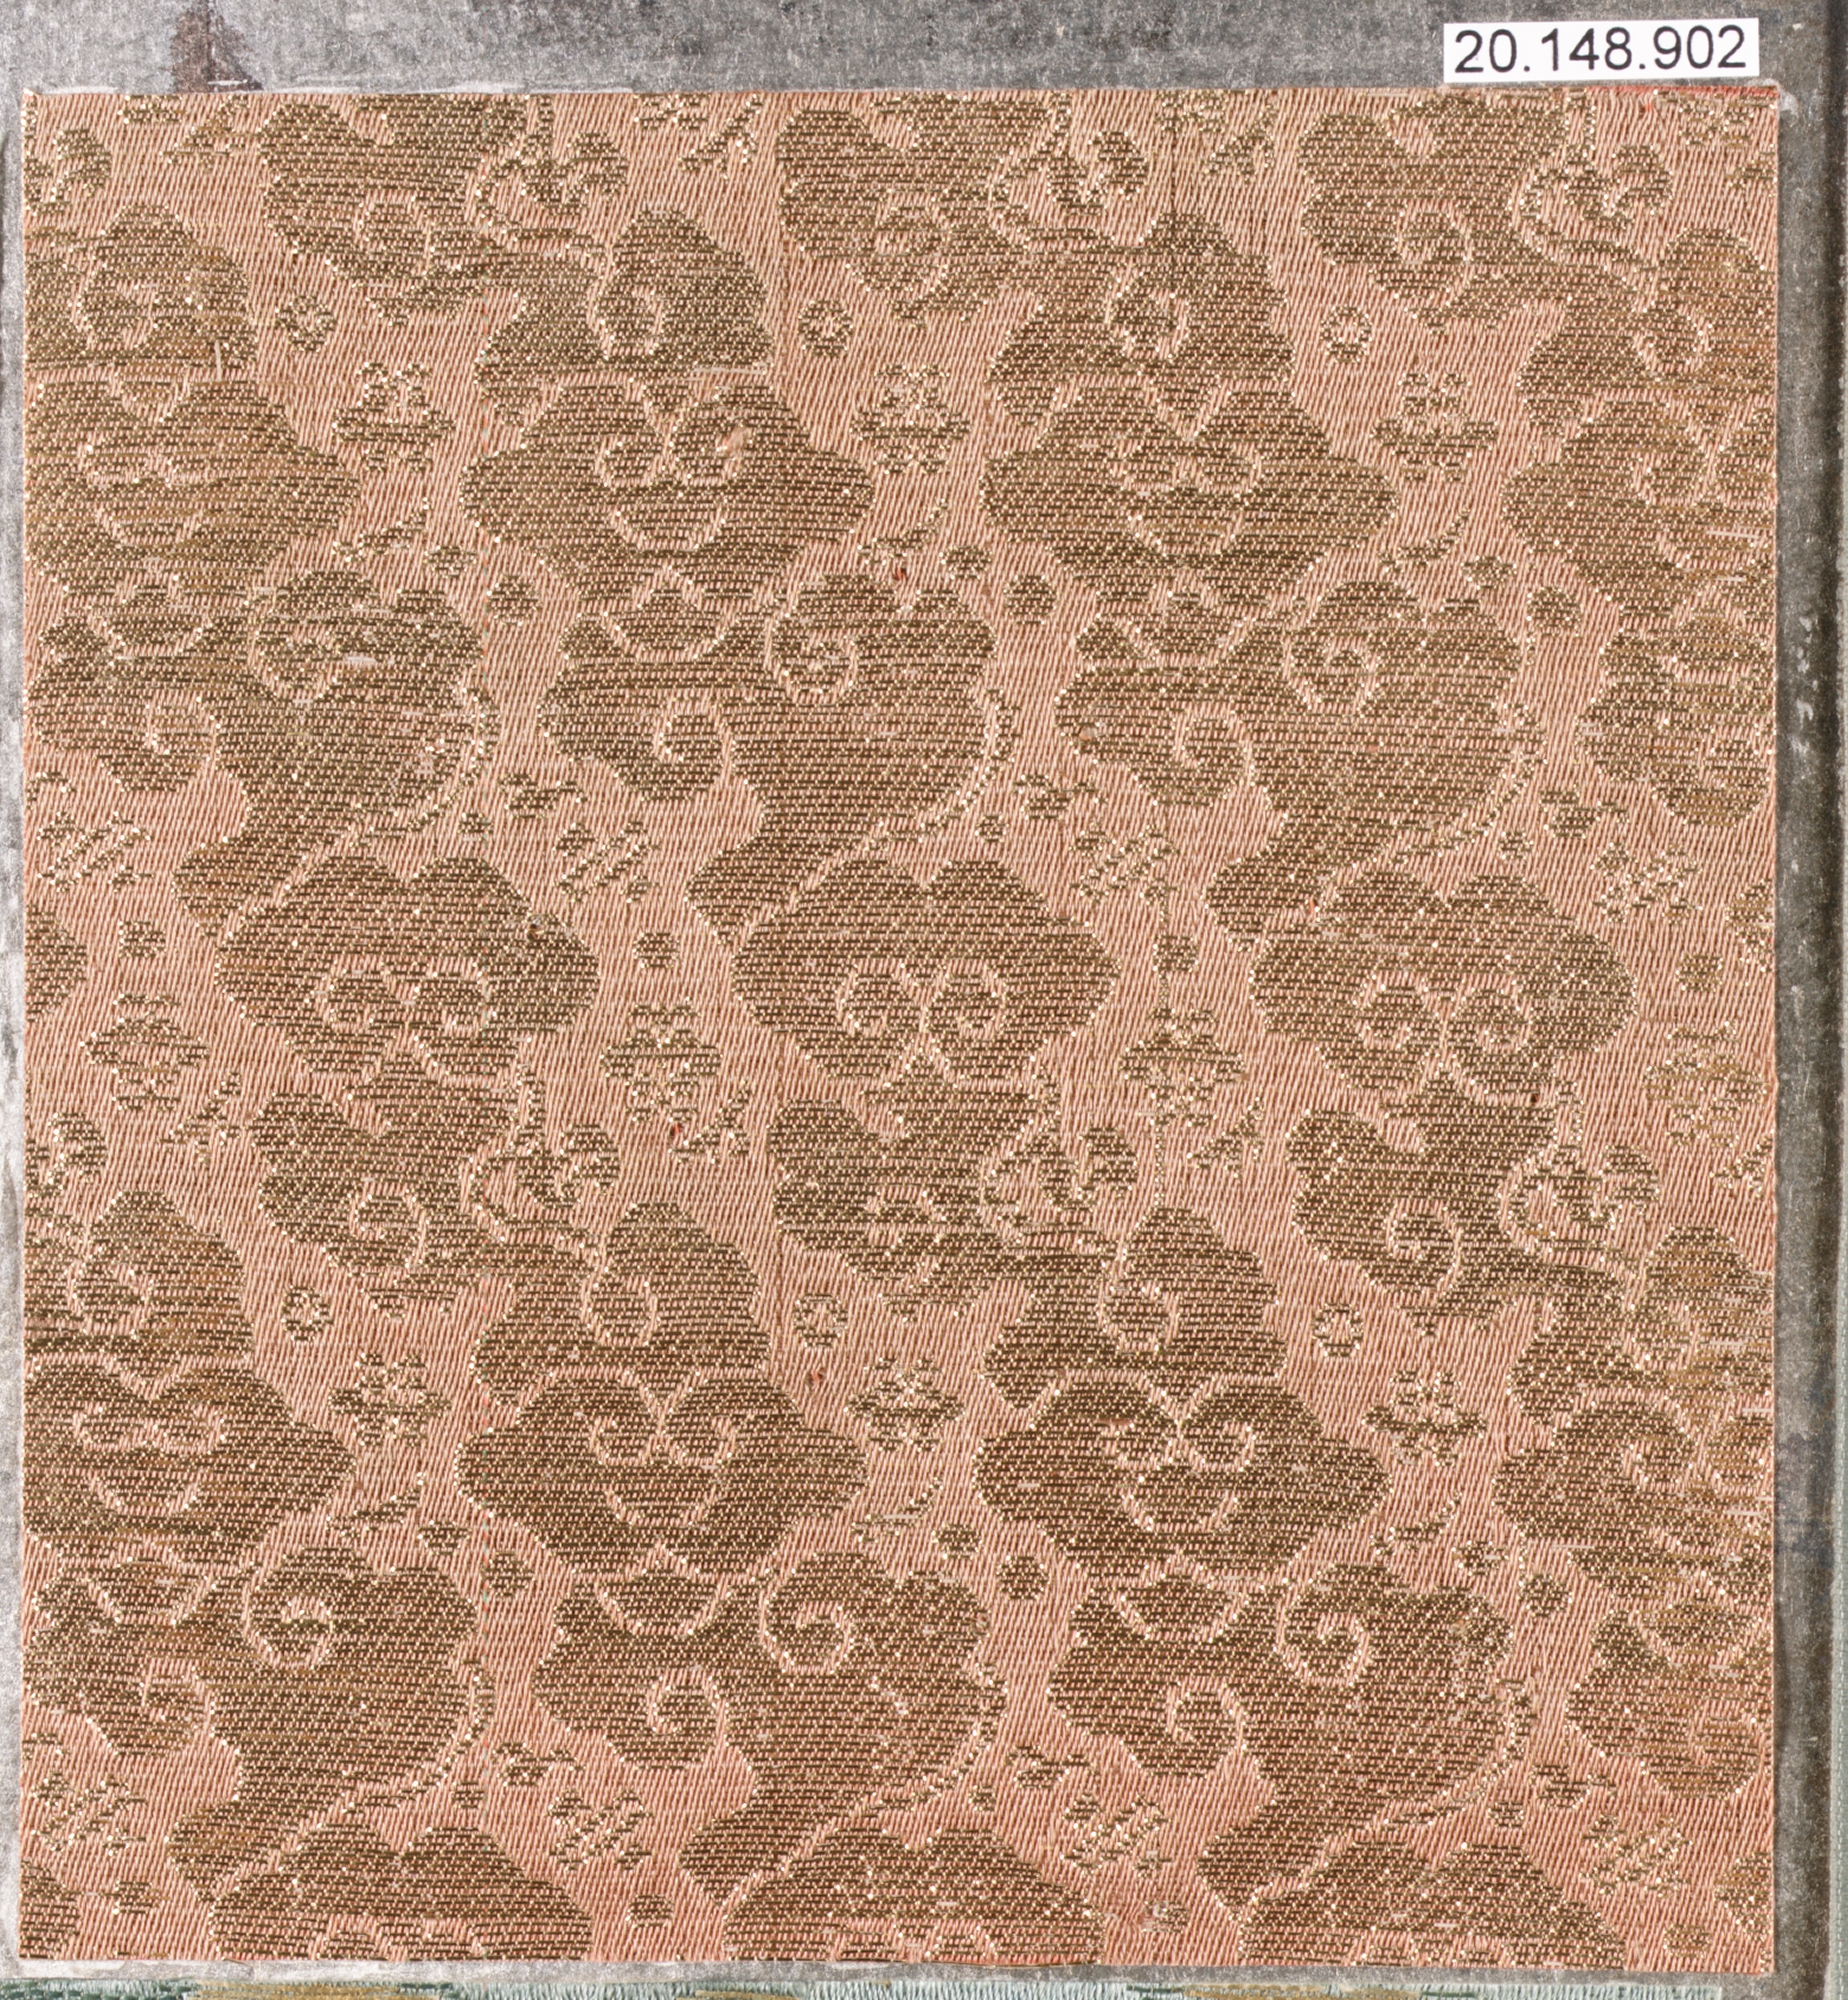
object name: piece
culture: japanese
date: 1701-1800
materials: silk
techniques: compound weave